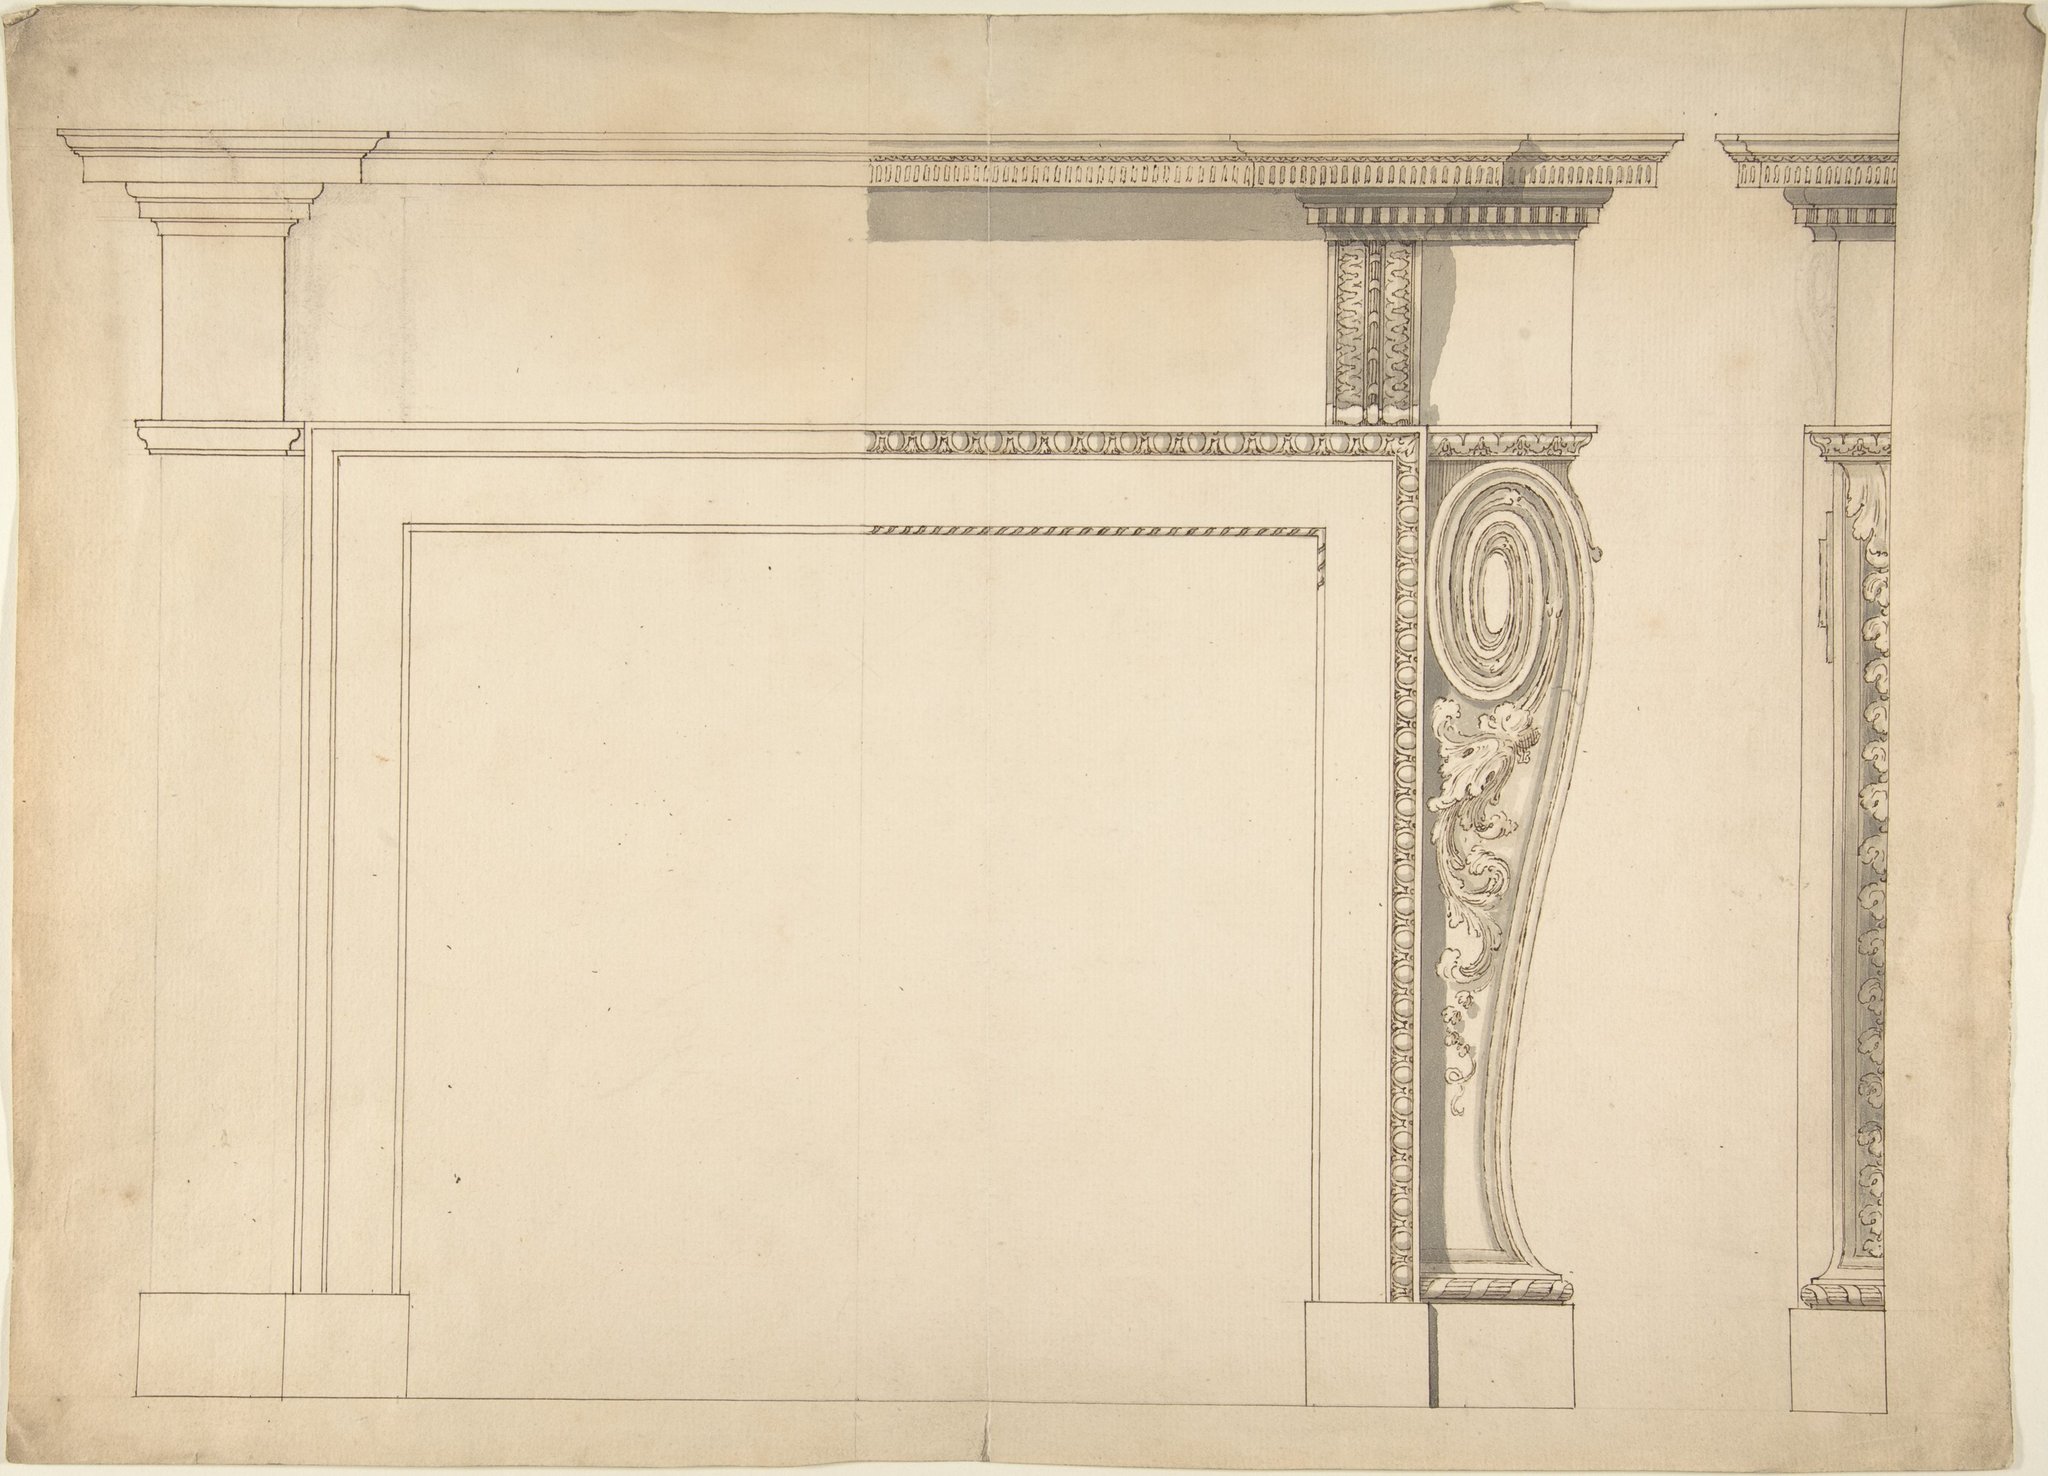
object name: drawing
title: Design for a Chimneypiece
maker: sir william chambers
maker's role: artist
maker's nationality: british, born sweden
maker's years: 1723-1796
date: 1740-1800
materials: ink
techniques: brush, pen, wash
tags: fireplaces